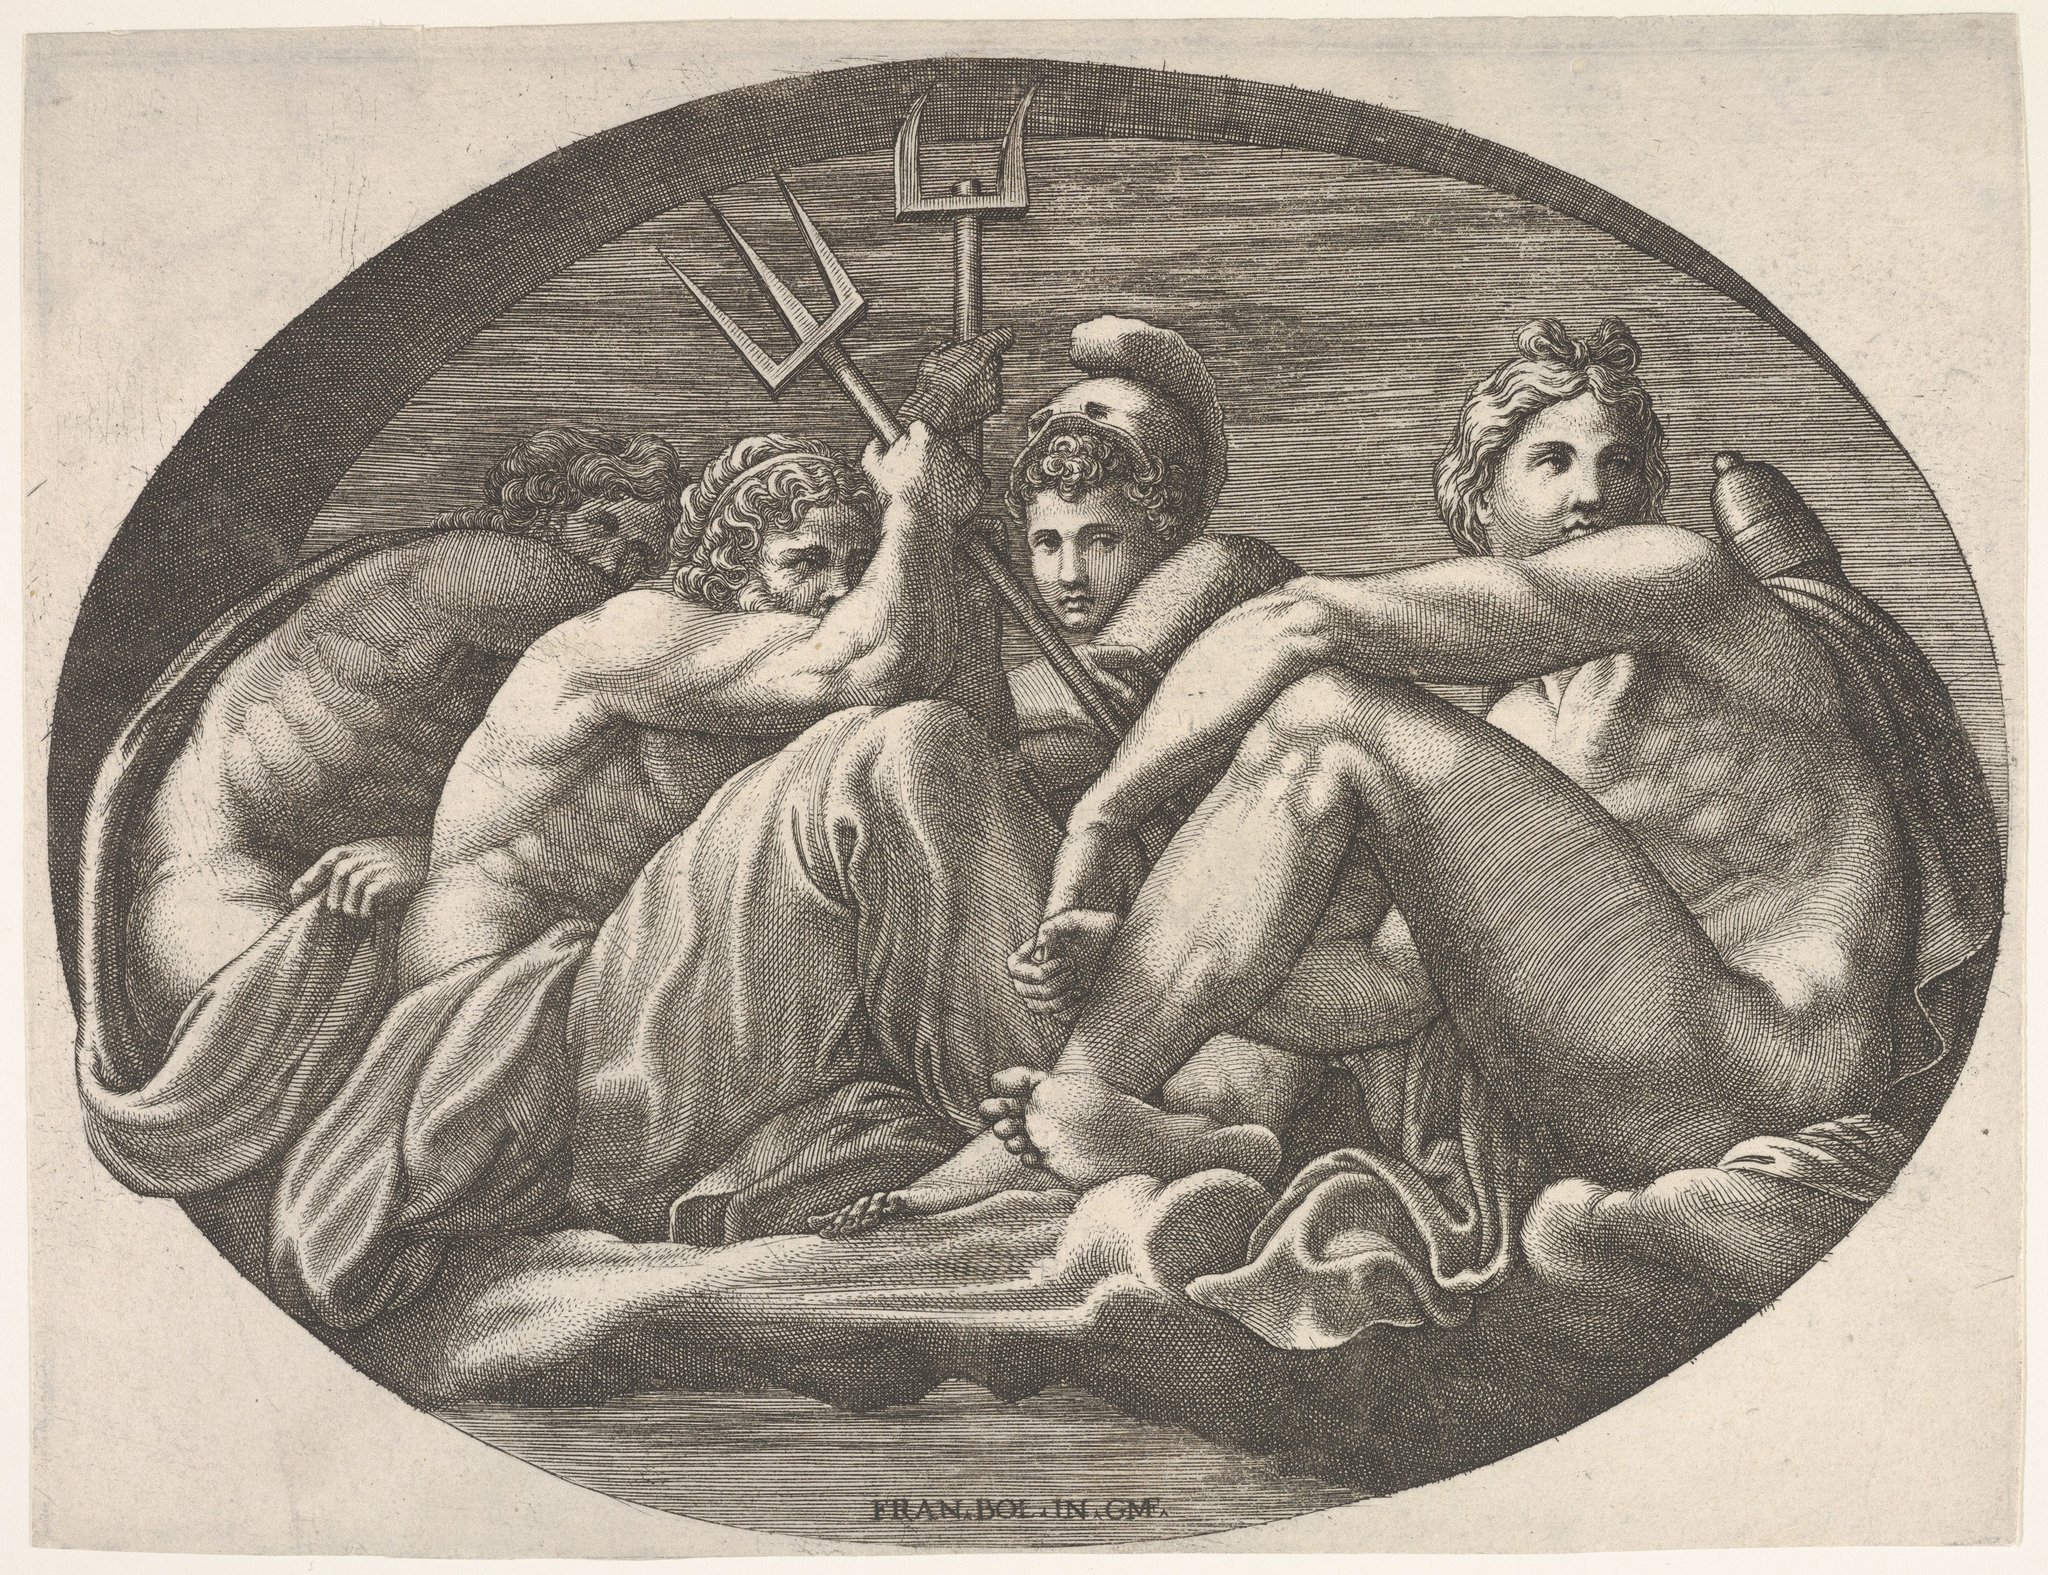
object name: print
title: Apollo, Neptune, Pluto, and Athena seated on a cloud under an arch, an oval composition, from a series of eight compositions after Francesco Primaticcio's designs for the ceiling of the Ulysses Gallery (destroyed 1738-39) at Fontainebleau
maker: giorgio ghisi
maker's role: artist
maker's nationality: italian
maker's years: 1515-1582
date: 1560-1569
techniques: engraving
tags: apollo,athena,neptune,pluto